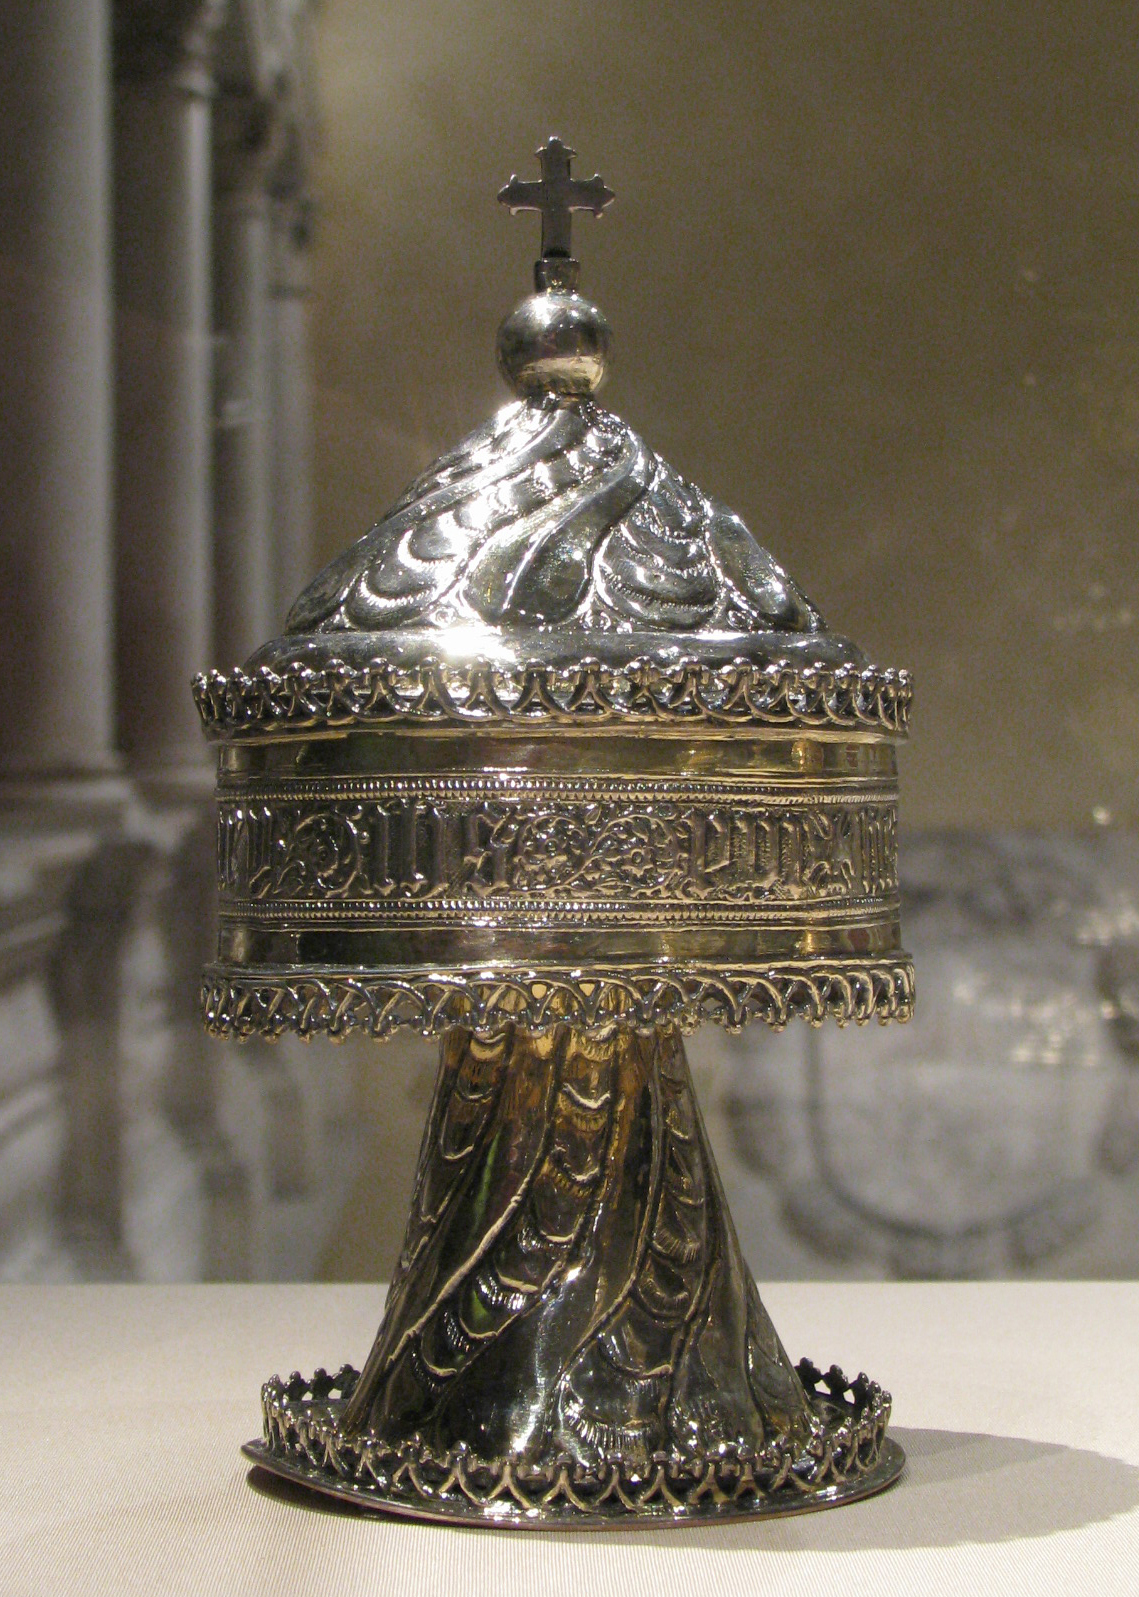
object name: pyx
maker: gaspar gallo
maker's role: artist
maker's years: 1500-1600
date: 1534-1566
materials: silver gilt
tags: cross